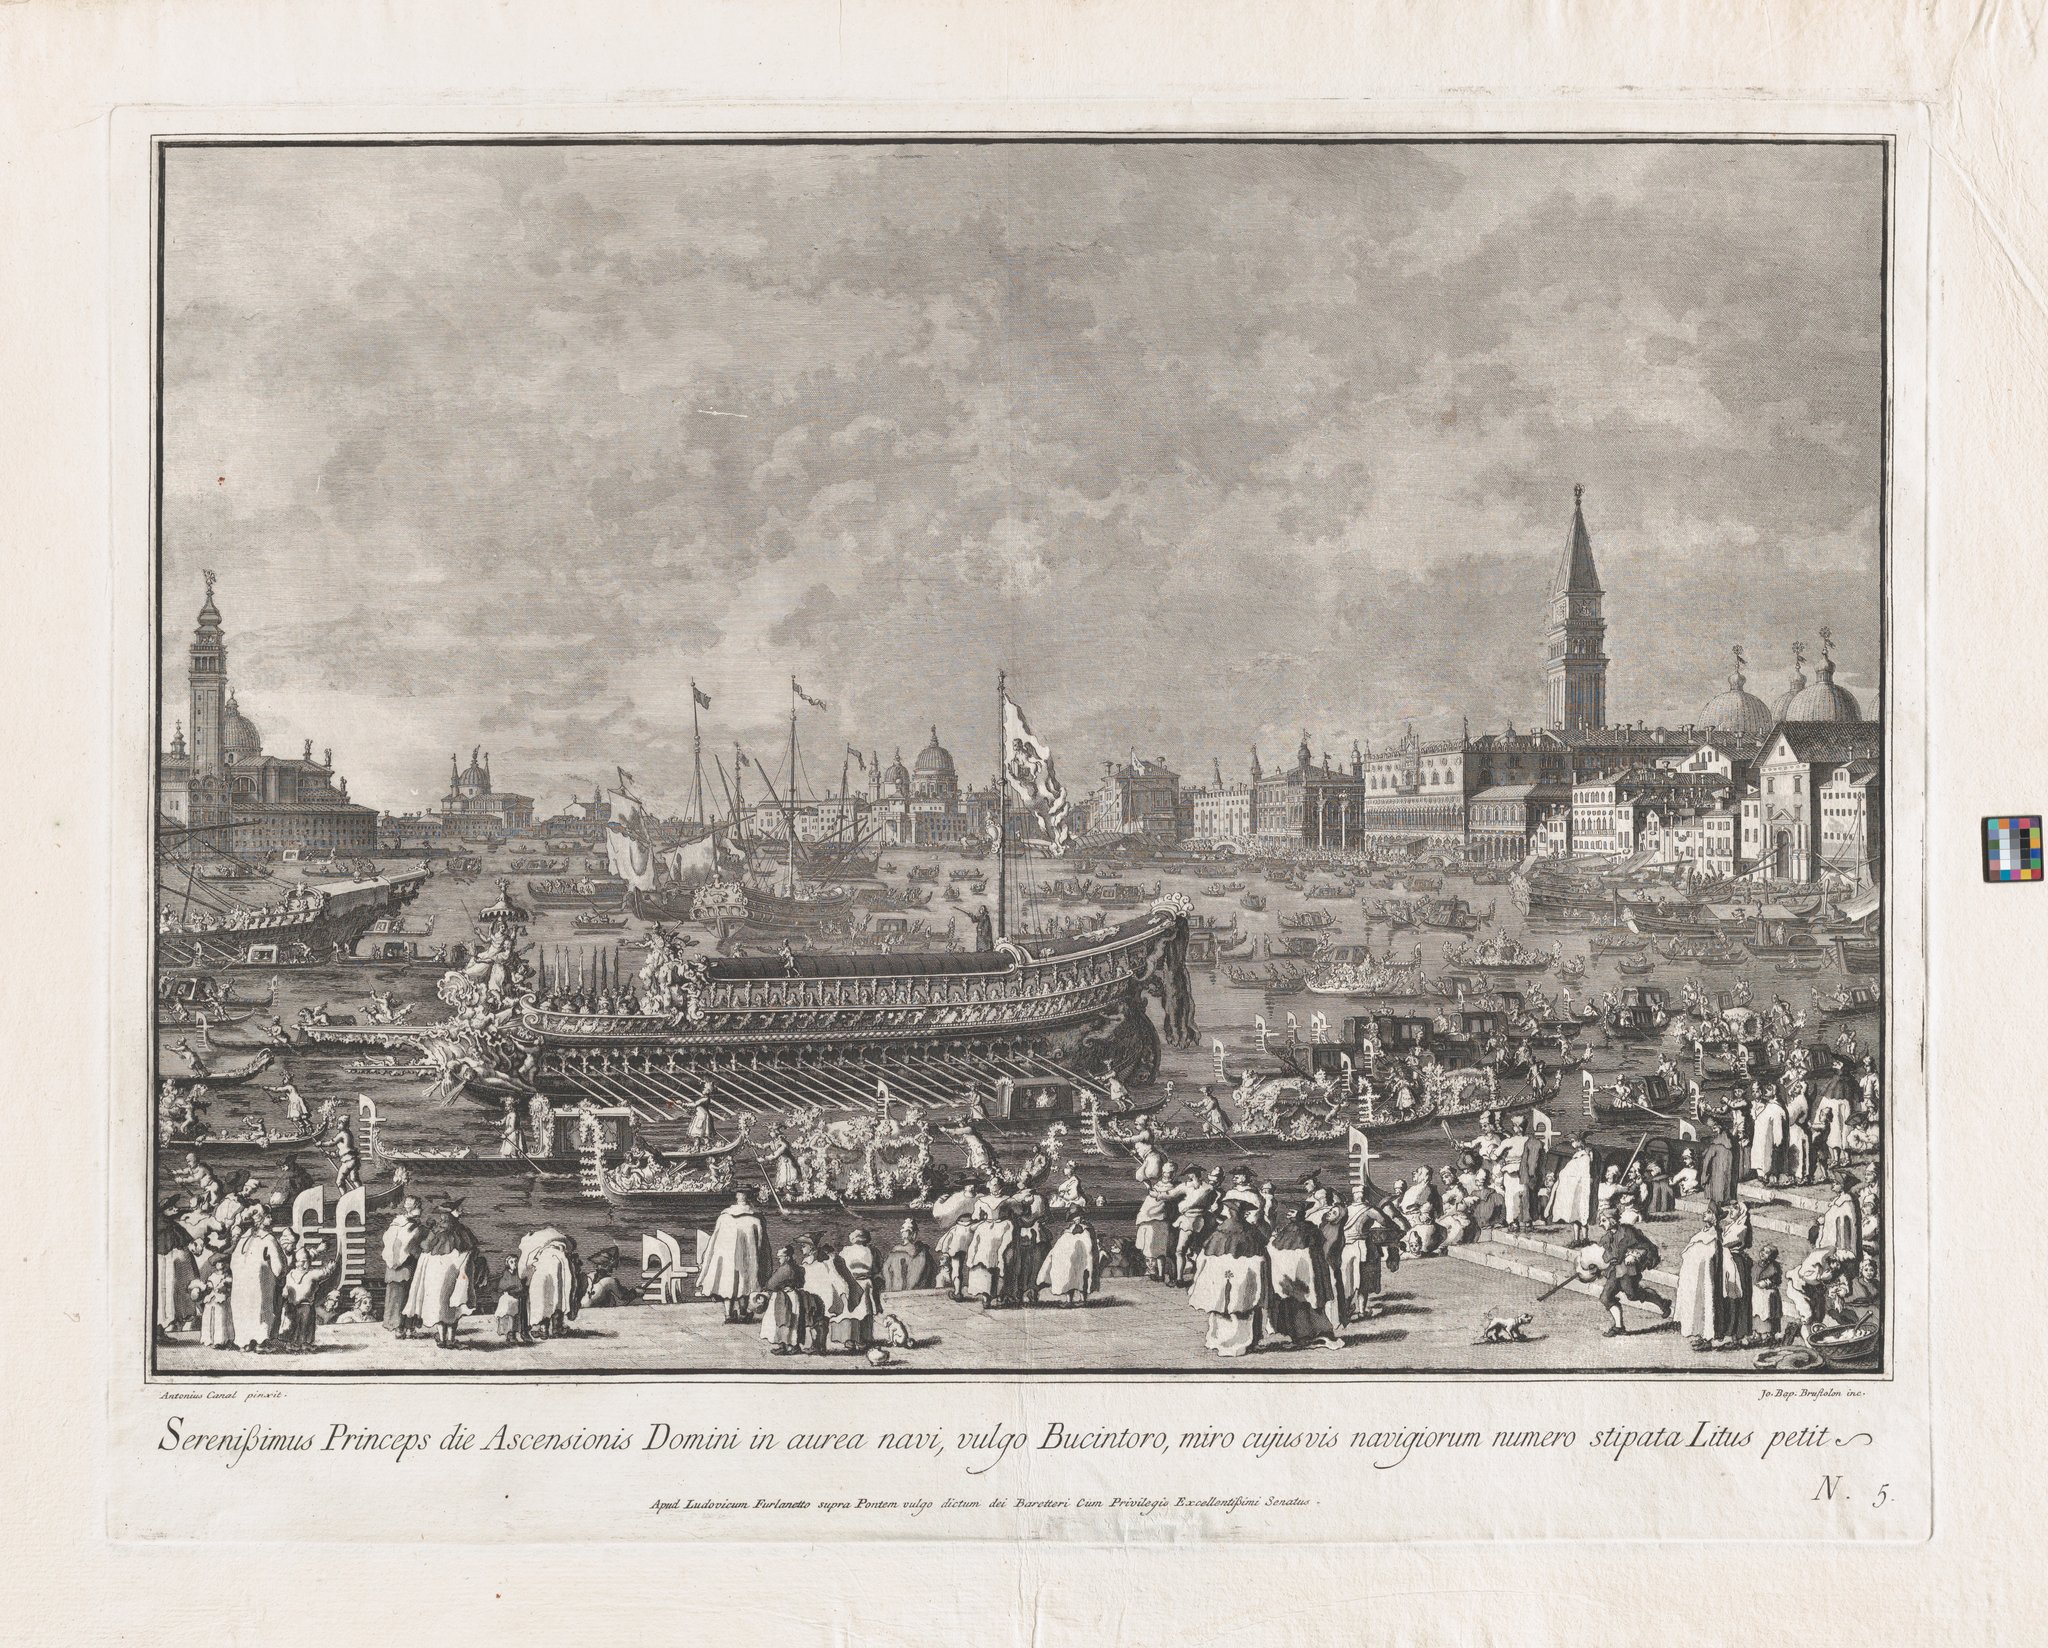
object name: print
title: Plate 5: The Doge in the Bucintoro Departing for the Porto di Lido on Ascension Day, from 'Ducal Ceremonies and Festivals' (Le Feste Ducali)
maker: giovanni battista brustolon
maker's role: artist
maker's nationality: italian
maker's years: 1712-1796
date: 1766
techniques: engraving, etching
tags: venice